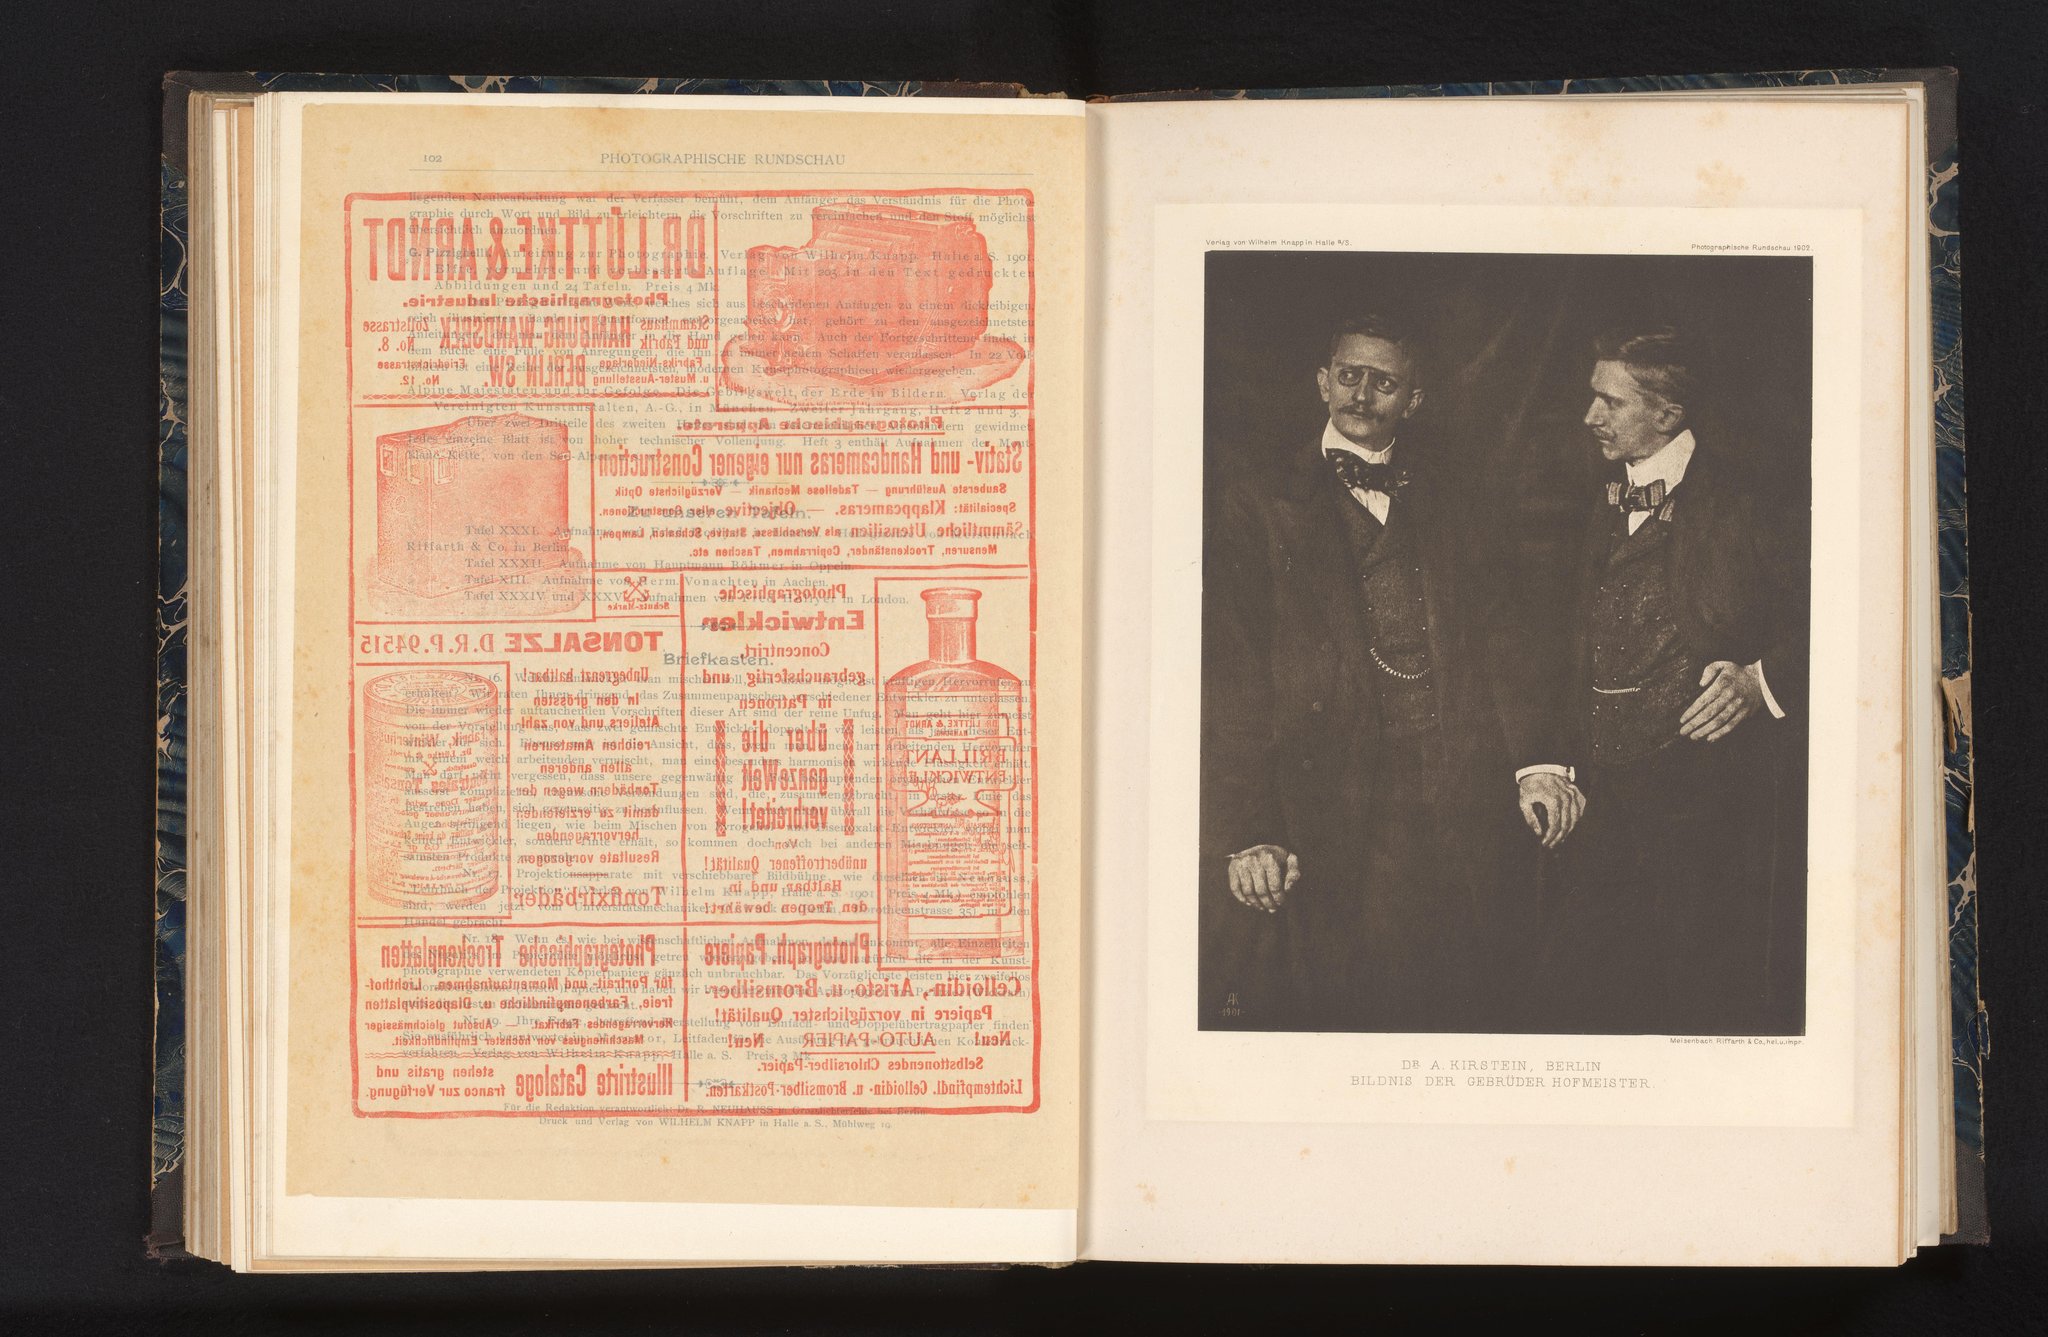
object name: page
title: Portret van de gebroeders Hofmeister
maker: alfred kirstein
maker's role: painter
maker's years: 1863-1922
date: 1897-1902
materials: paper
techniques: photoaquatint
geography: berlin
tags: adult man, historical persons